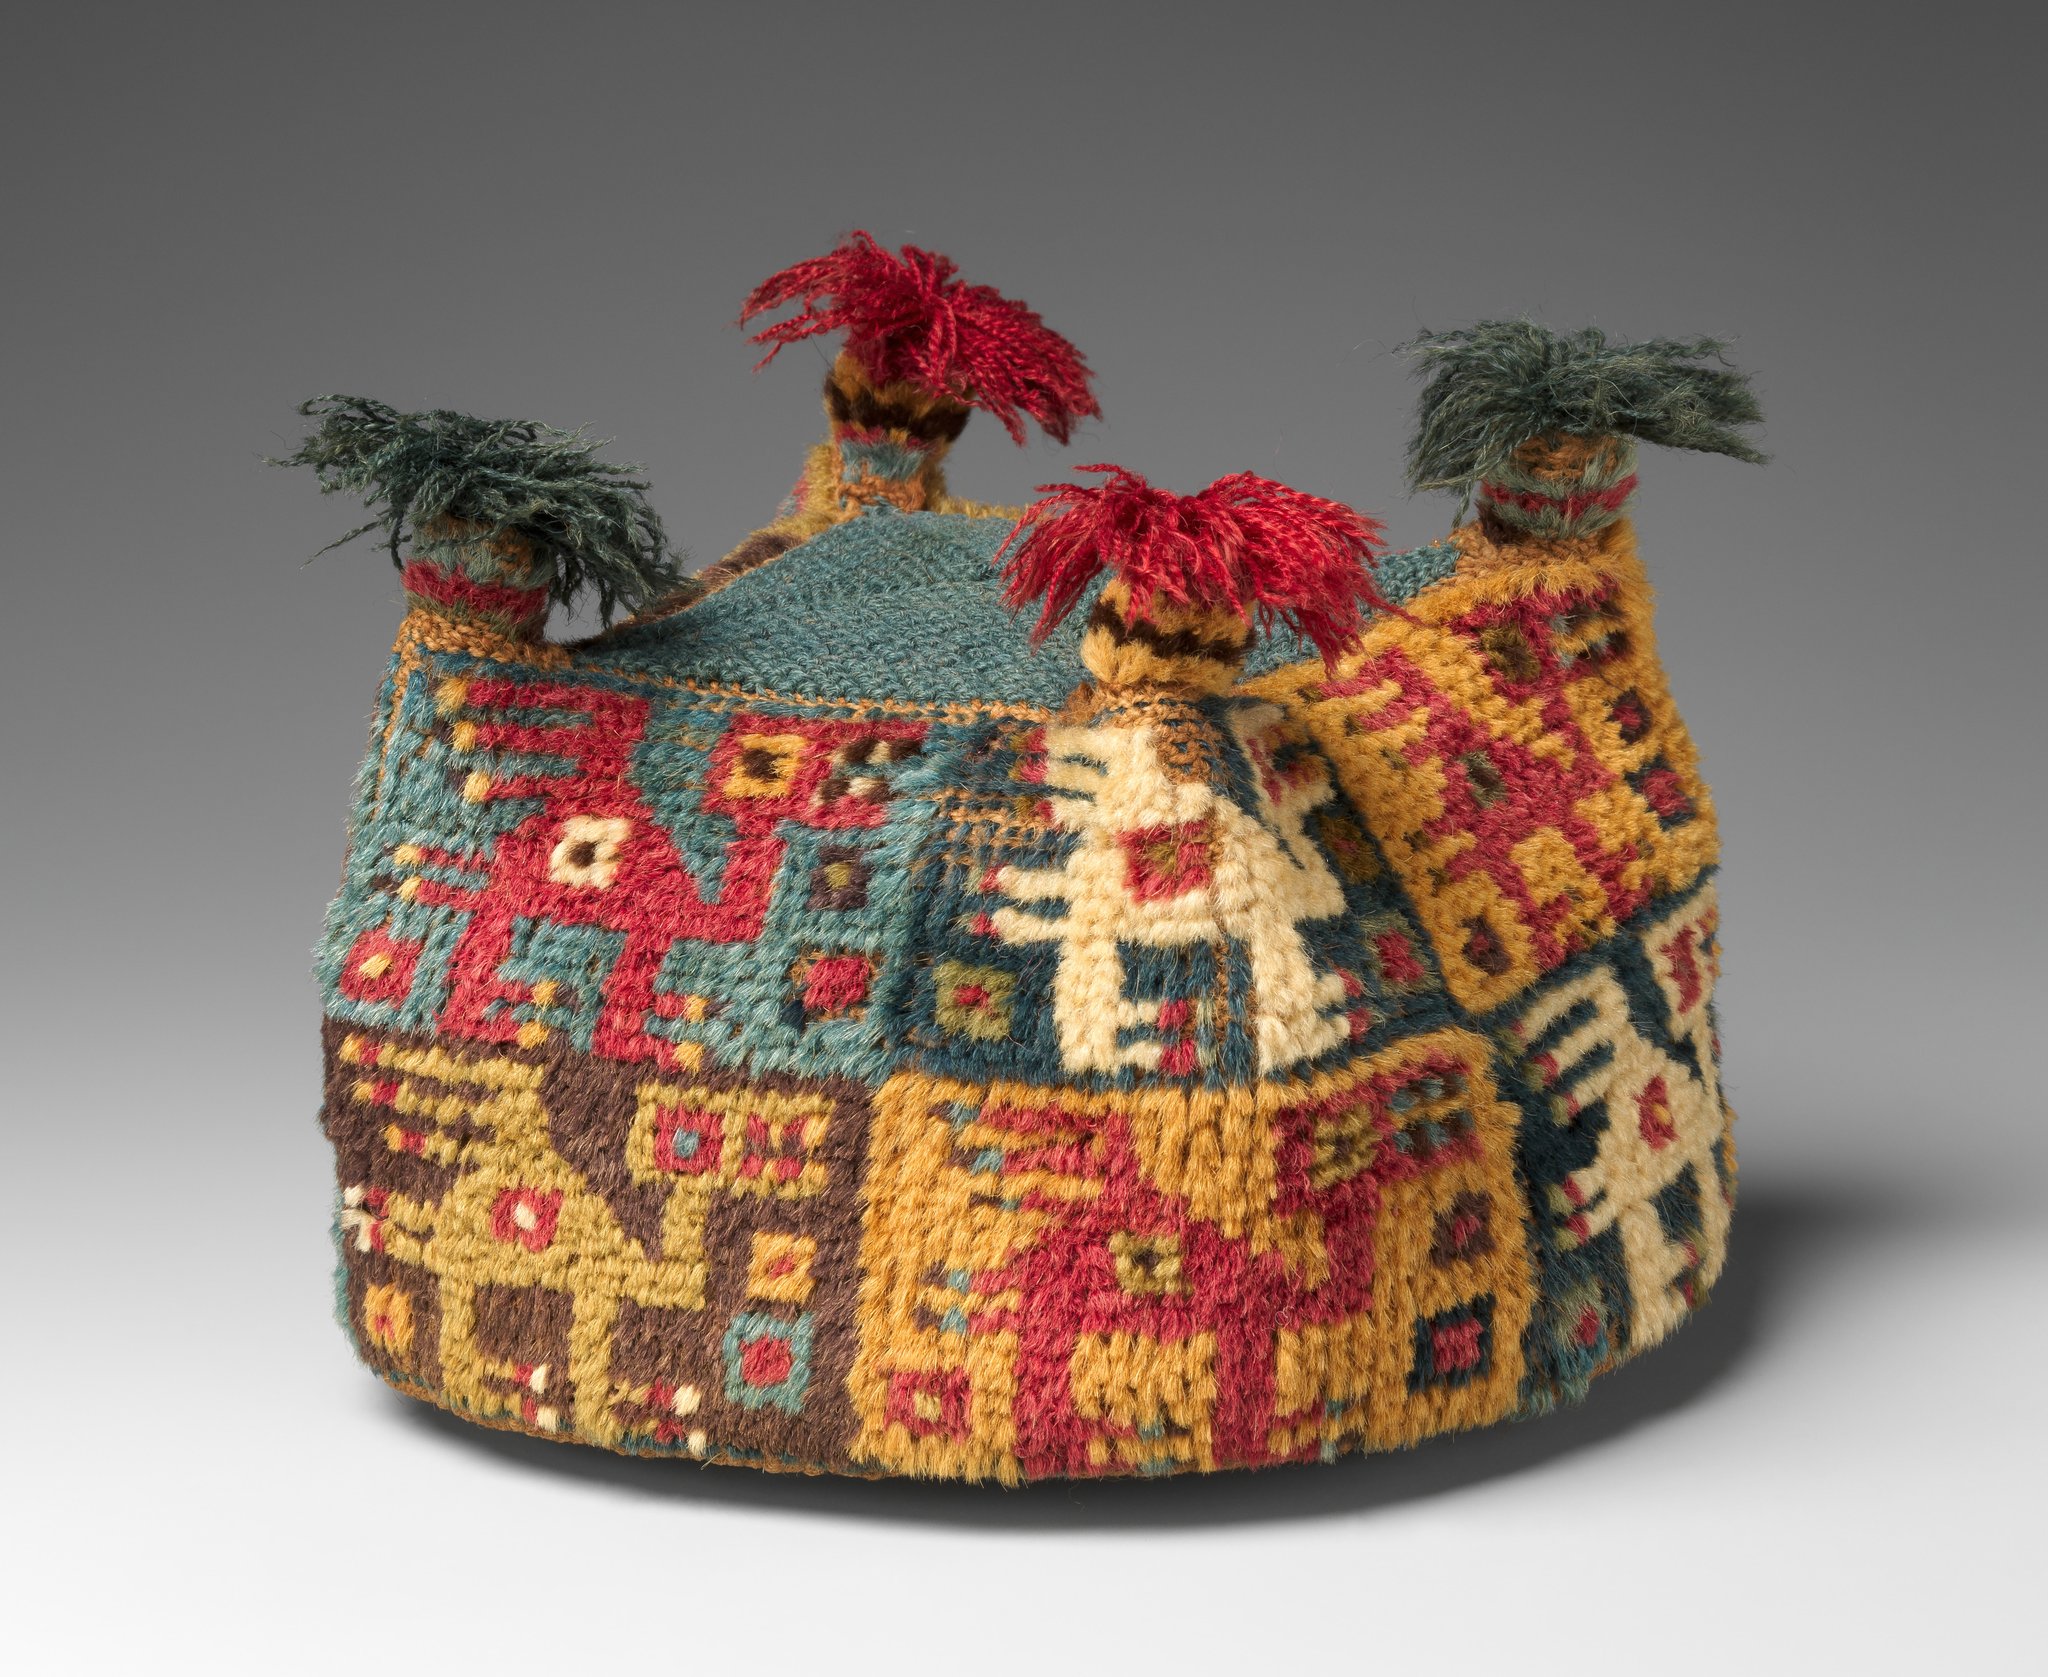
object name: hat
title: Four-Cornered Hat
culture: wari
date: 601-900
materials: animal fiber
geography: peru